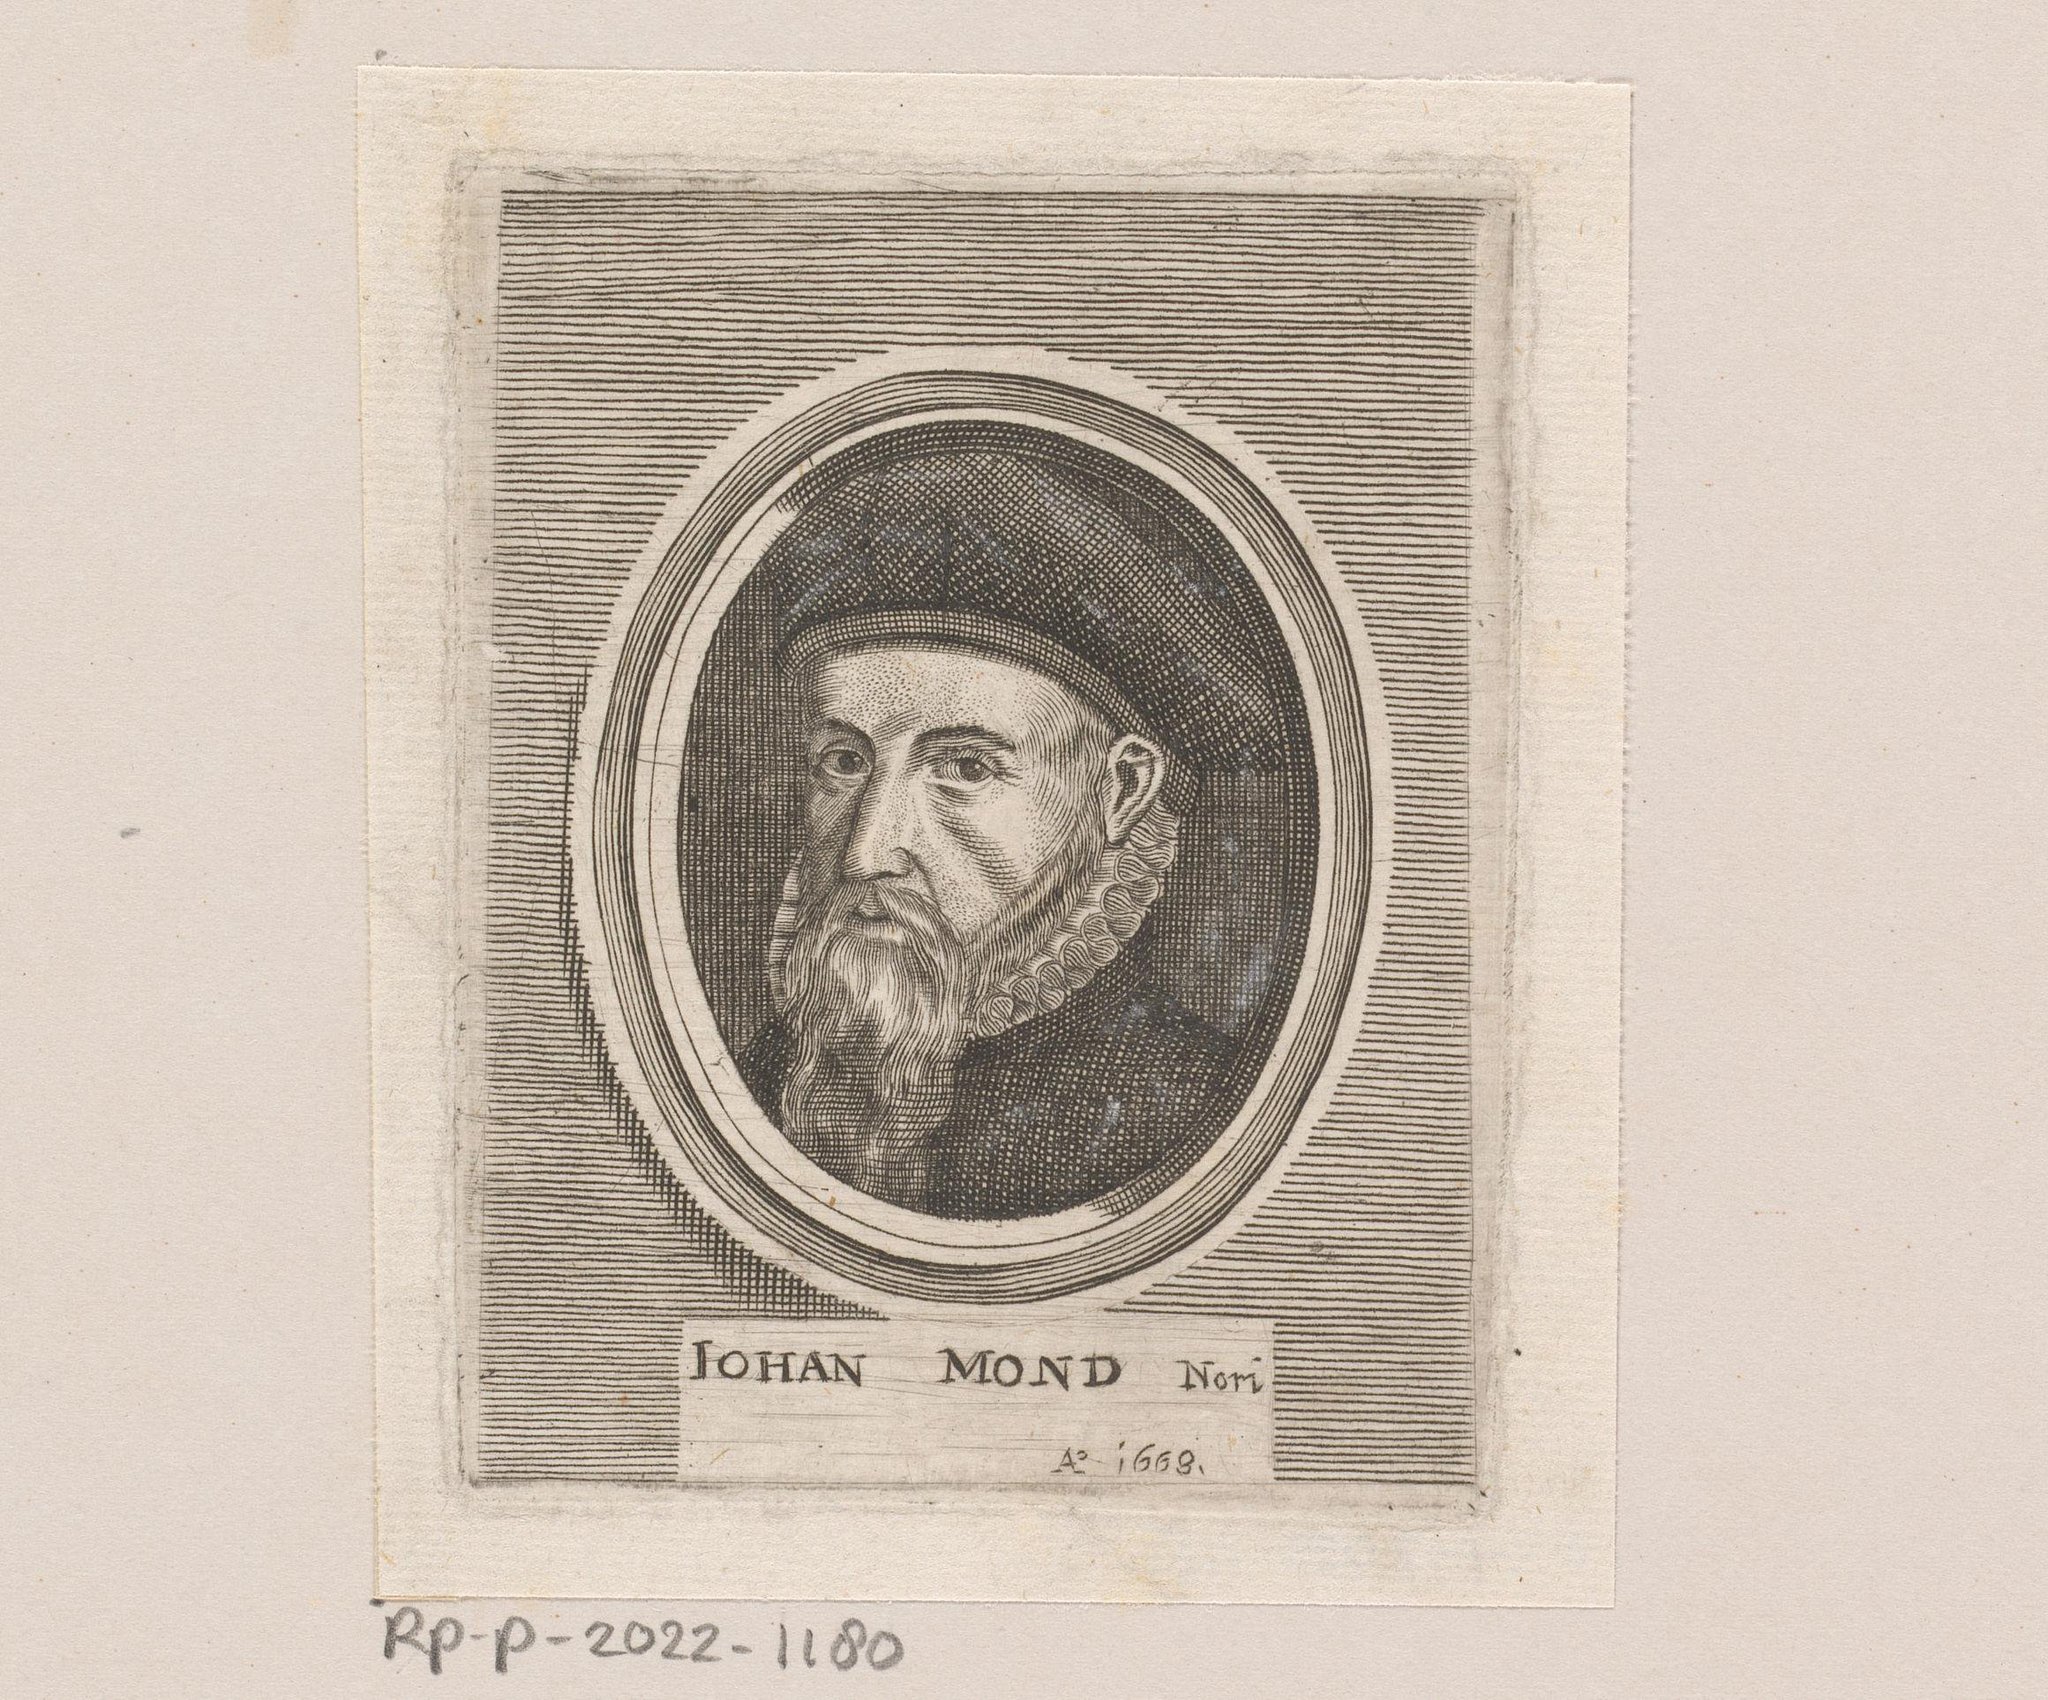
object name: print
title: Protret van Johann Mond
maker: Anonymous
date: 1668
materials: paper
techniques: engraving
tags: historical persons